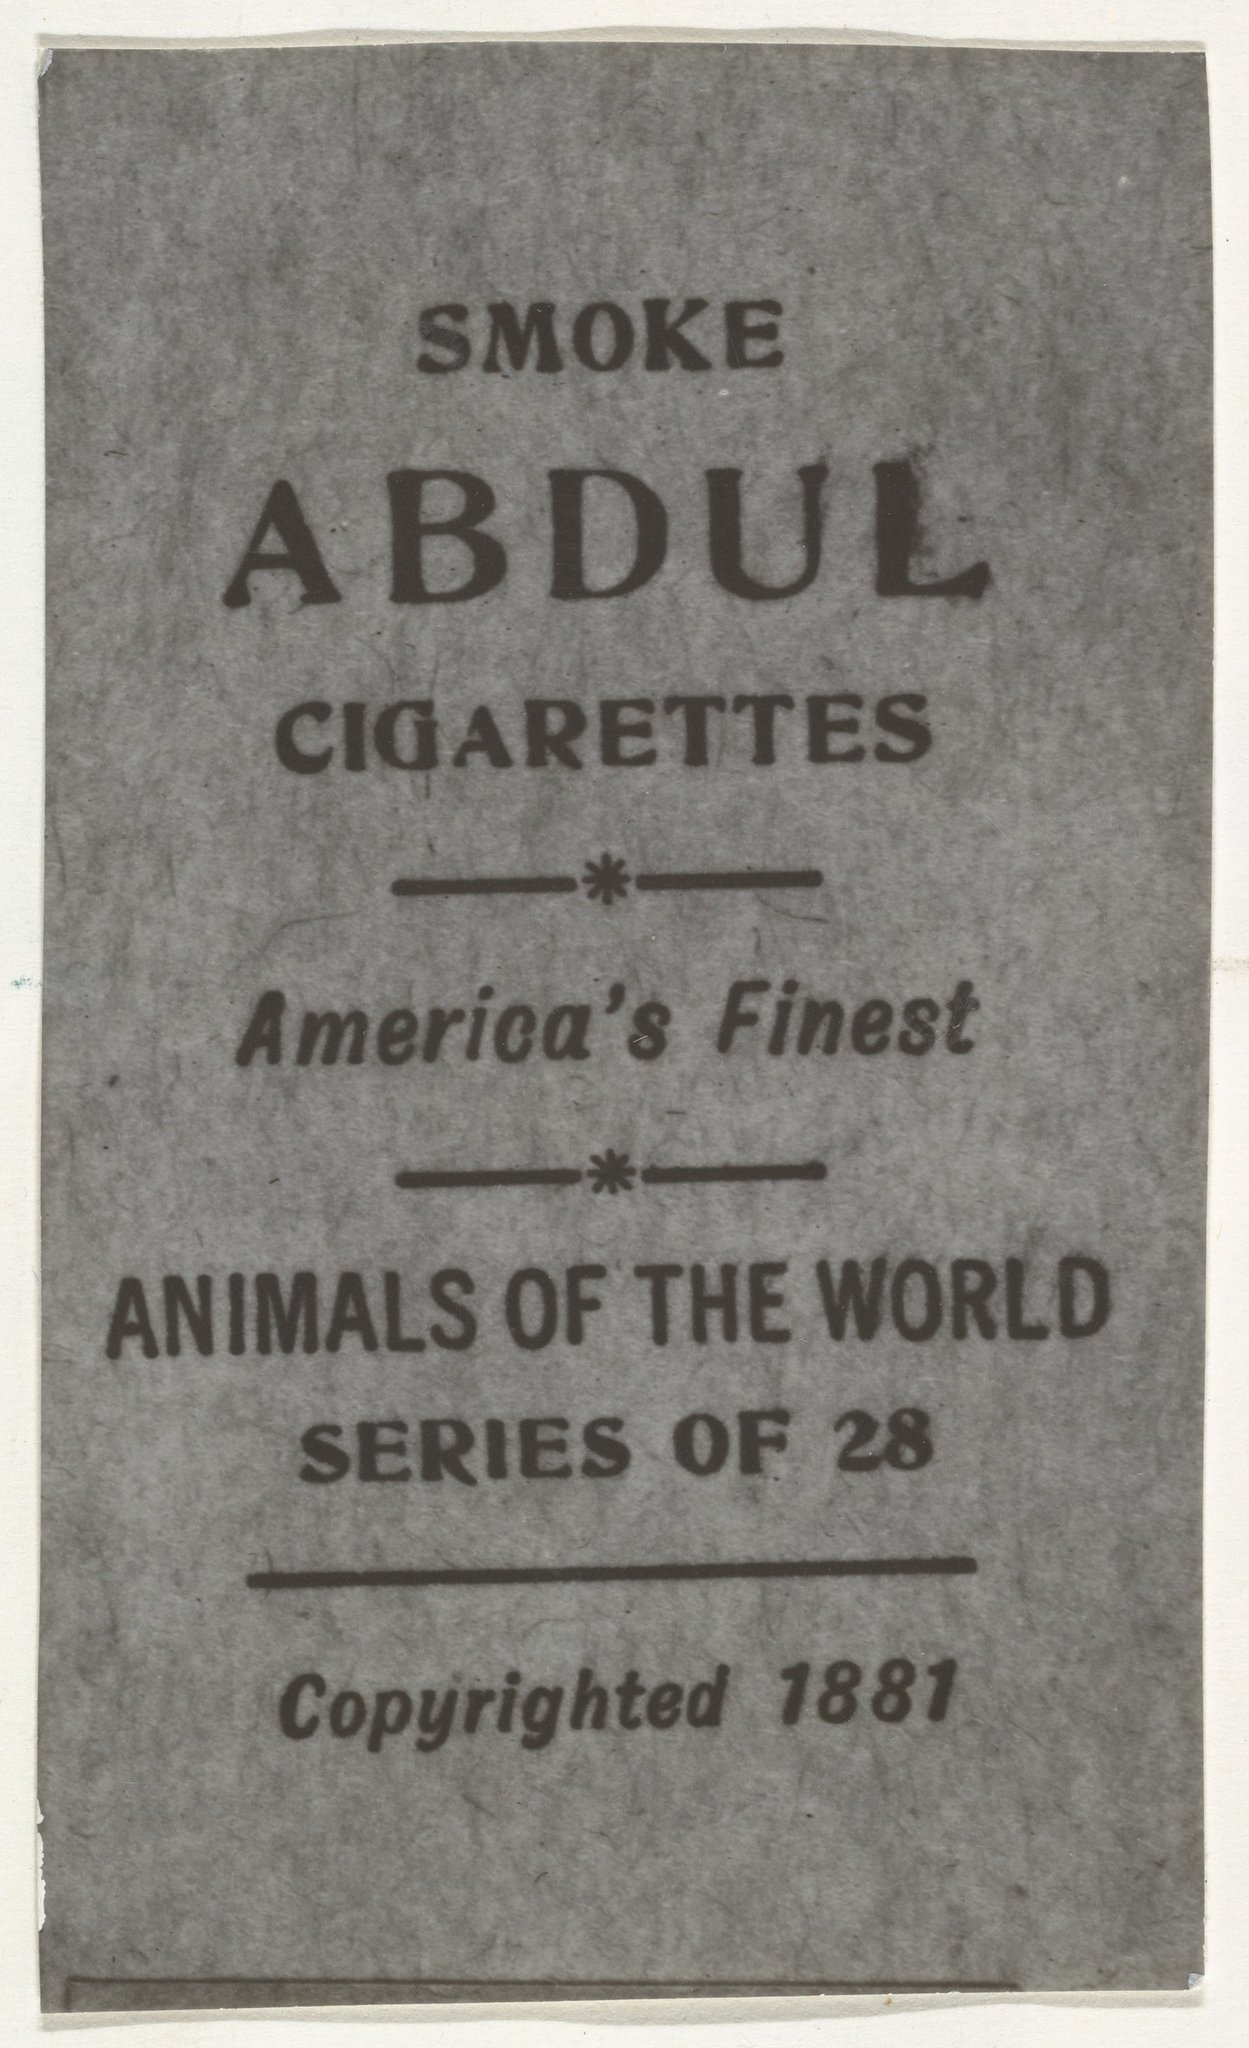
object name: print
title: Facsimile of card verso from the Animals of the World series (T180), issued by Abdul Cigarettes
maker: abdul cigarettes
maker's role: publisher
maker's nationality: american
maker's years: 1881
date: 1881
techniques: color lithograph